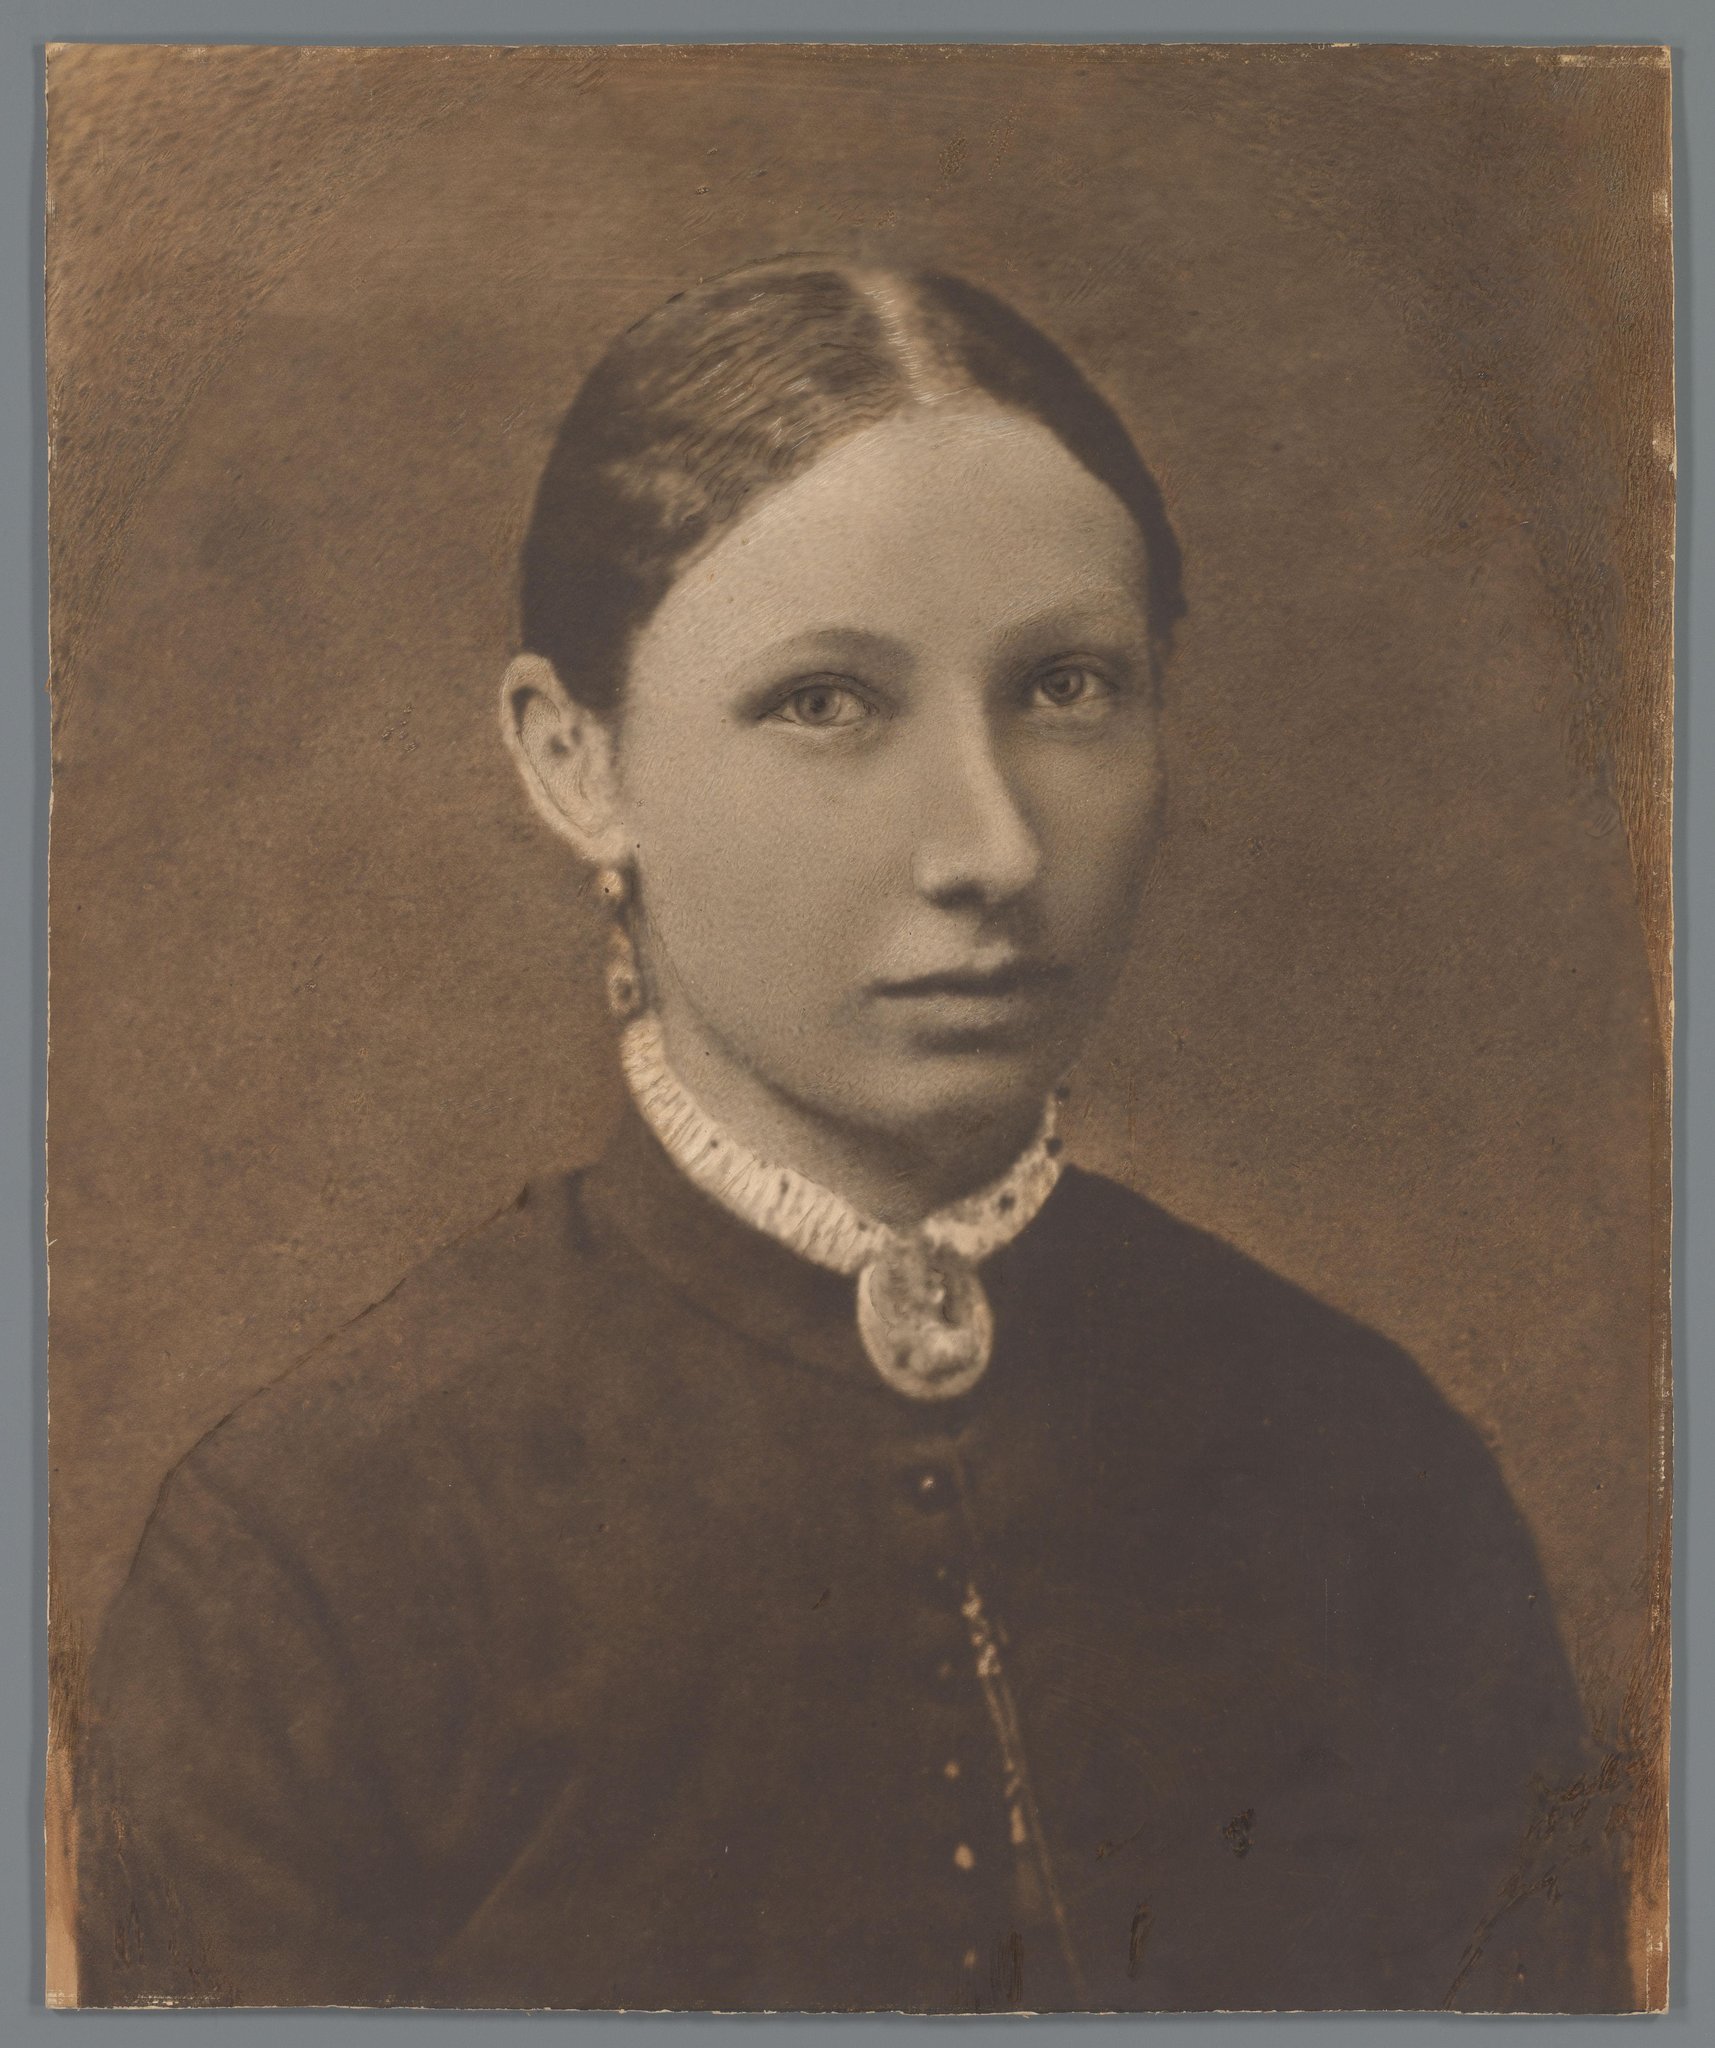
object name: photograph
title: Portret van een onbekende jonge vrouw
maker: Anonymous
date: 1880-1910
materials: paper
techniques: gelatin silver print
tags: anonymous historical person portrayed - bb - woman